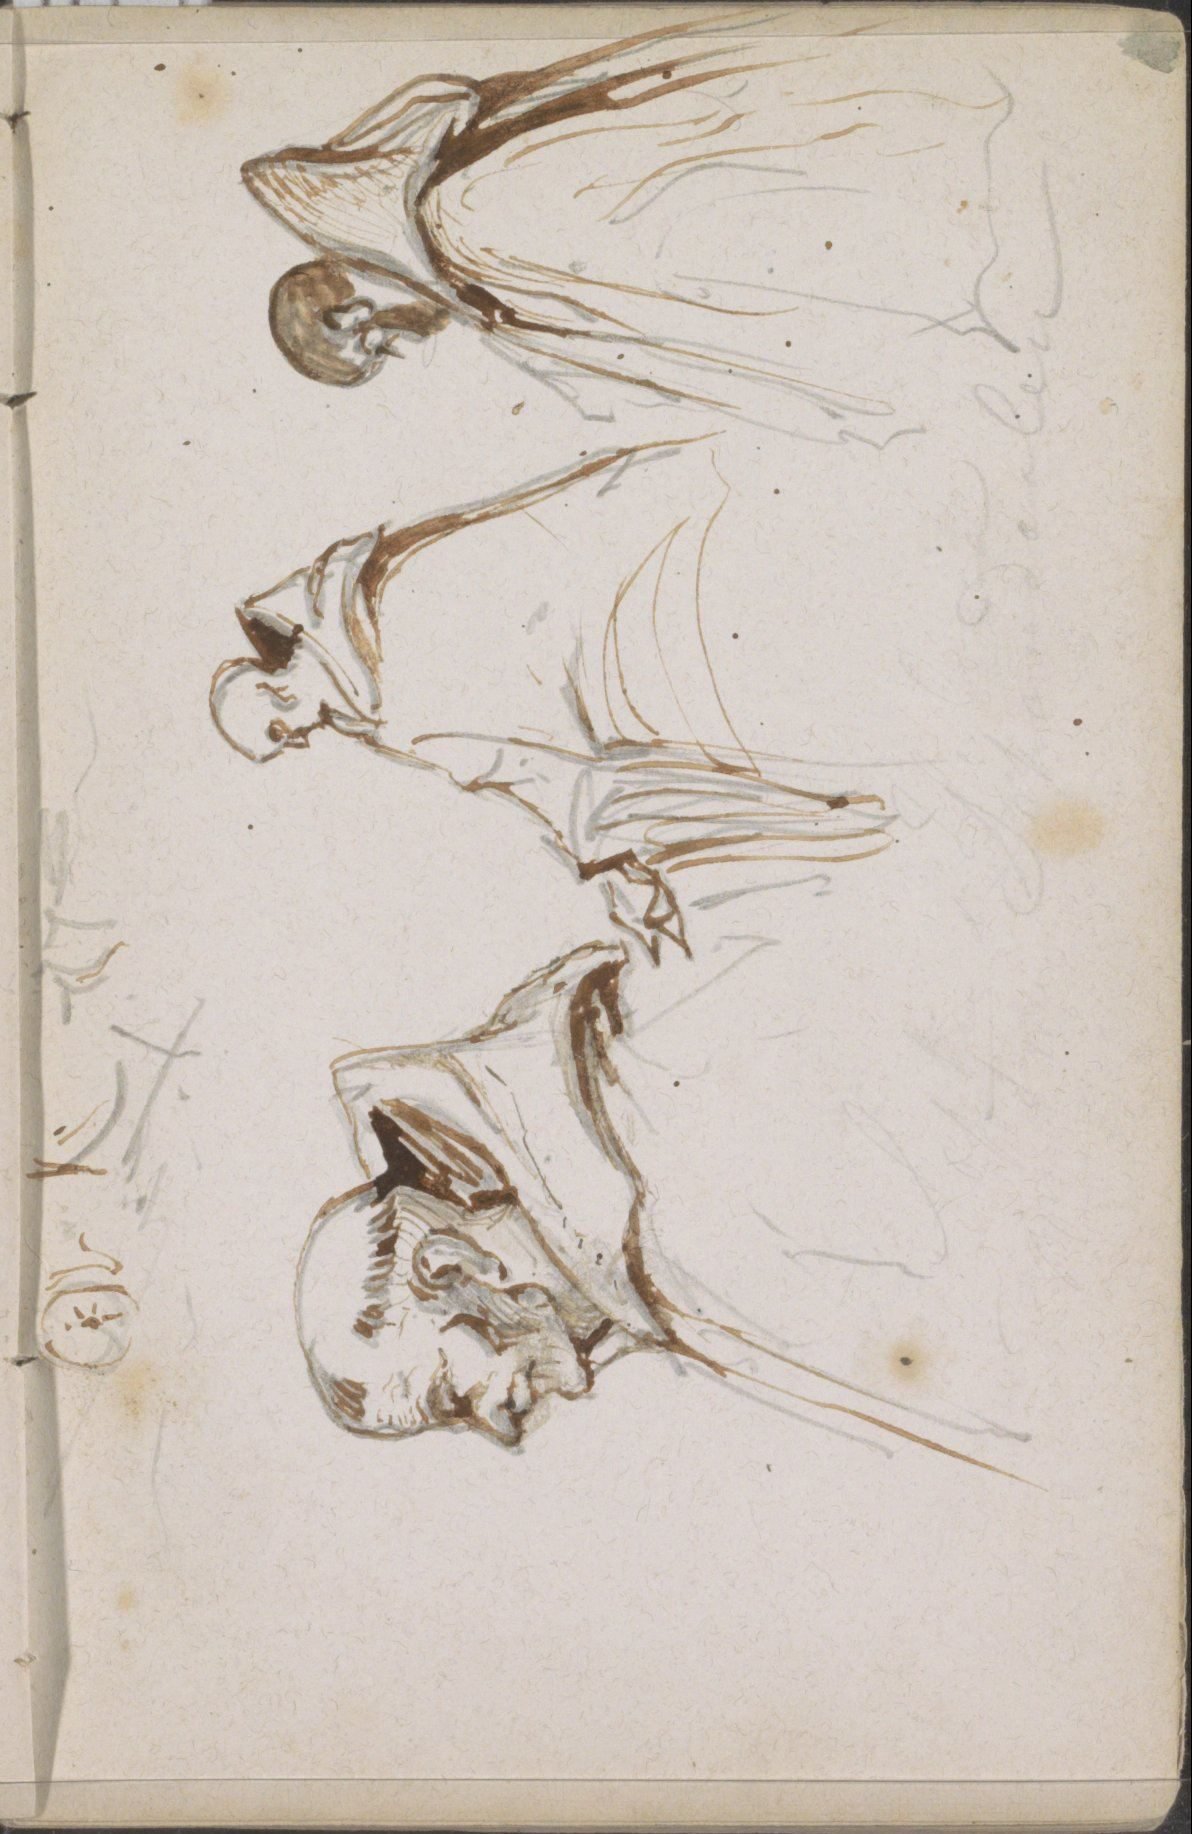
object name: sketchbook leaf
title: Monniken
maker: johannes tavenraat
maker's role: draughtsman, painter, print maker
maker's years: 1809-1881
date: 1862-1864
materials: ink, paper, pencil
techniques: pen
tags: monk(s), friar(s)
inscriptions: annotation: ‘[...]daalen’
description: Blad 13 recto uit een schetsboek met 65 bladen.